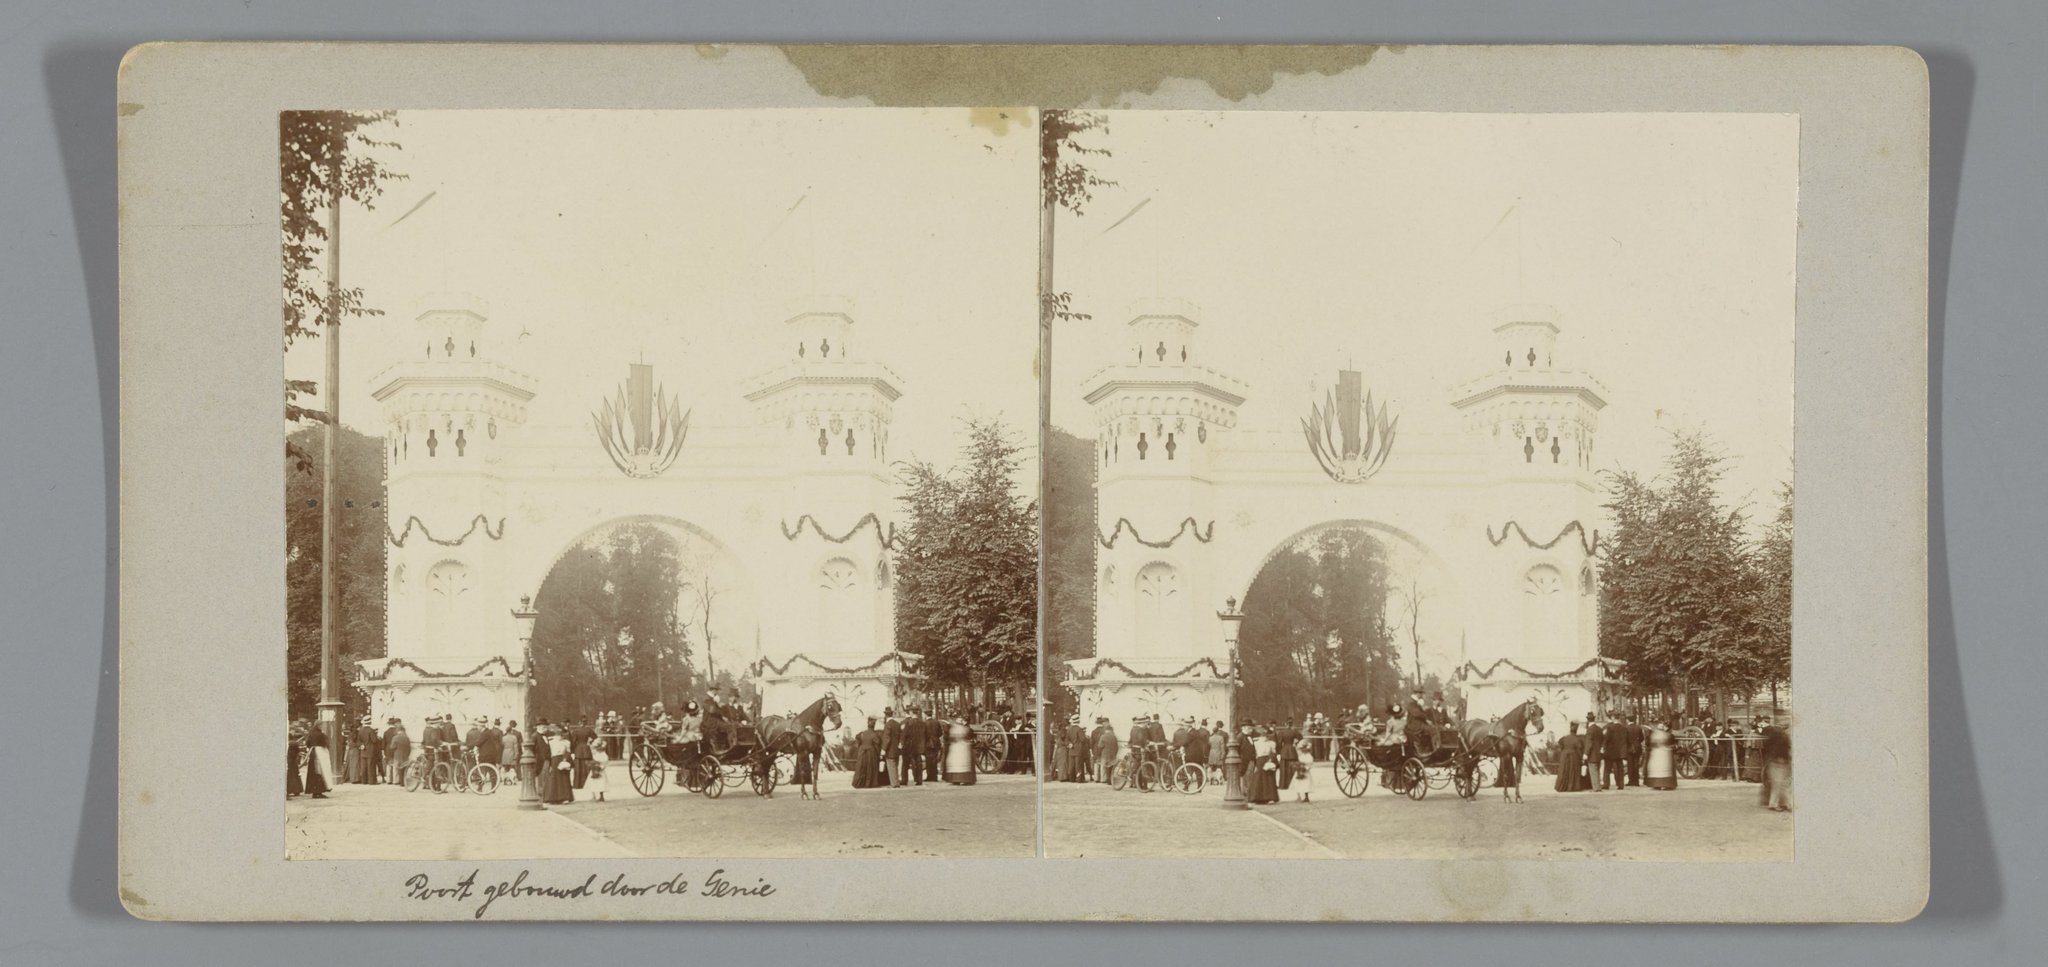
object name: stereograph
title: Erepoort van de genie van de Koninklijke Landmacht op de Mauritskade, gebouwd ter gelegenheid van de inhuldiging van koningin Wilhelmina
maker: Anonymous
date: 1898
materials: paper, cardboard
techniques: gelatin silver print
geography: amsterdam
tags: the hague, wilhelmina of the netherlands, gate, entrance, amsterdam